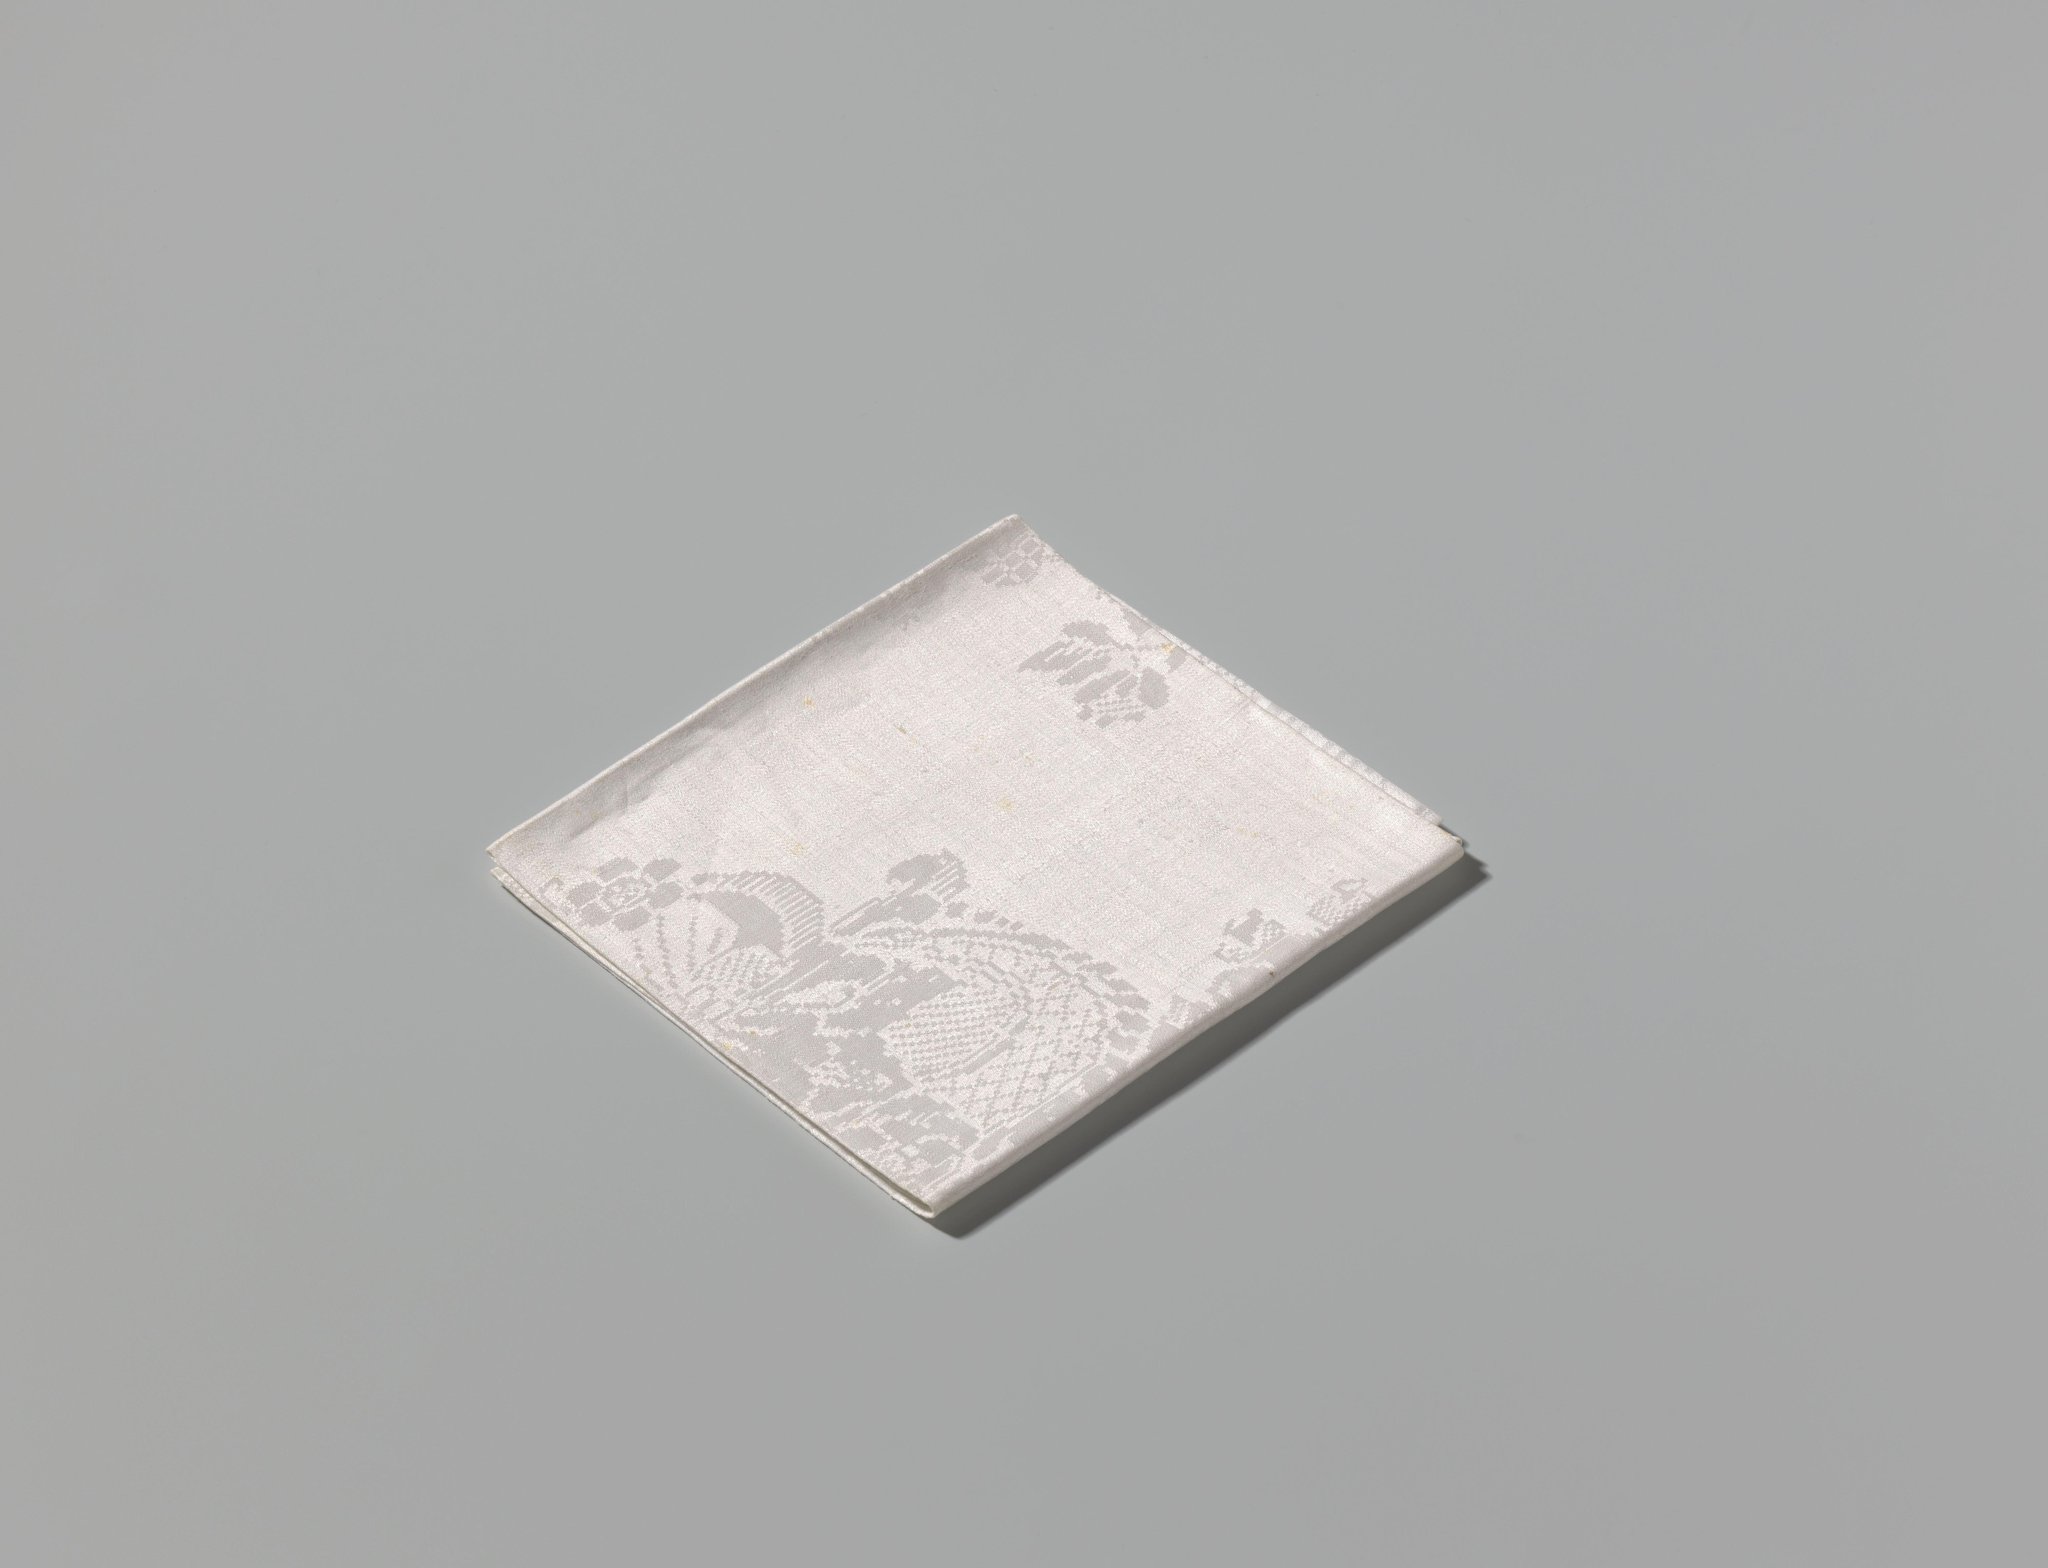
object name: napkin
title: Bloemornament. Merk: W 18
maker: Anonymous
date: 1725-1735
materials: linen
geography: germany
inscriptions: : ‘W 18 WH 2oonl’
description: Servet van wit linnen met een bloemenornament, merk W 18.